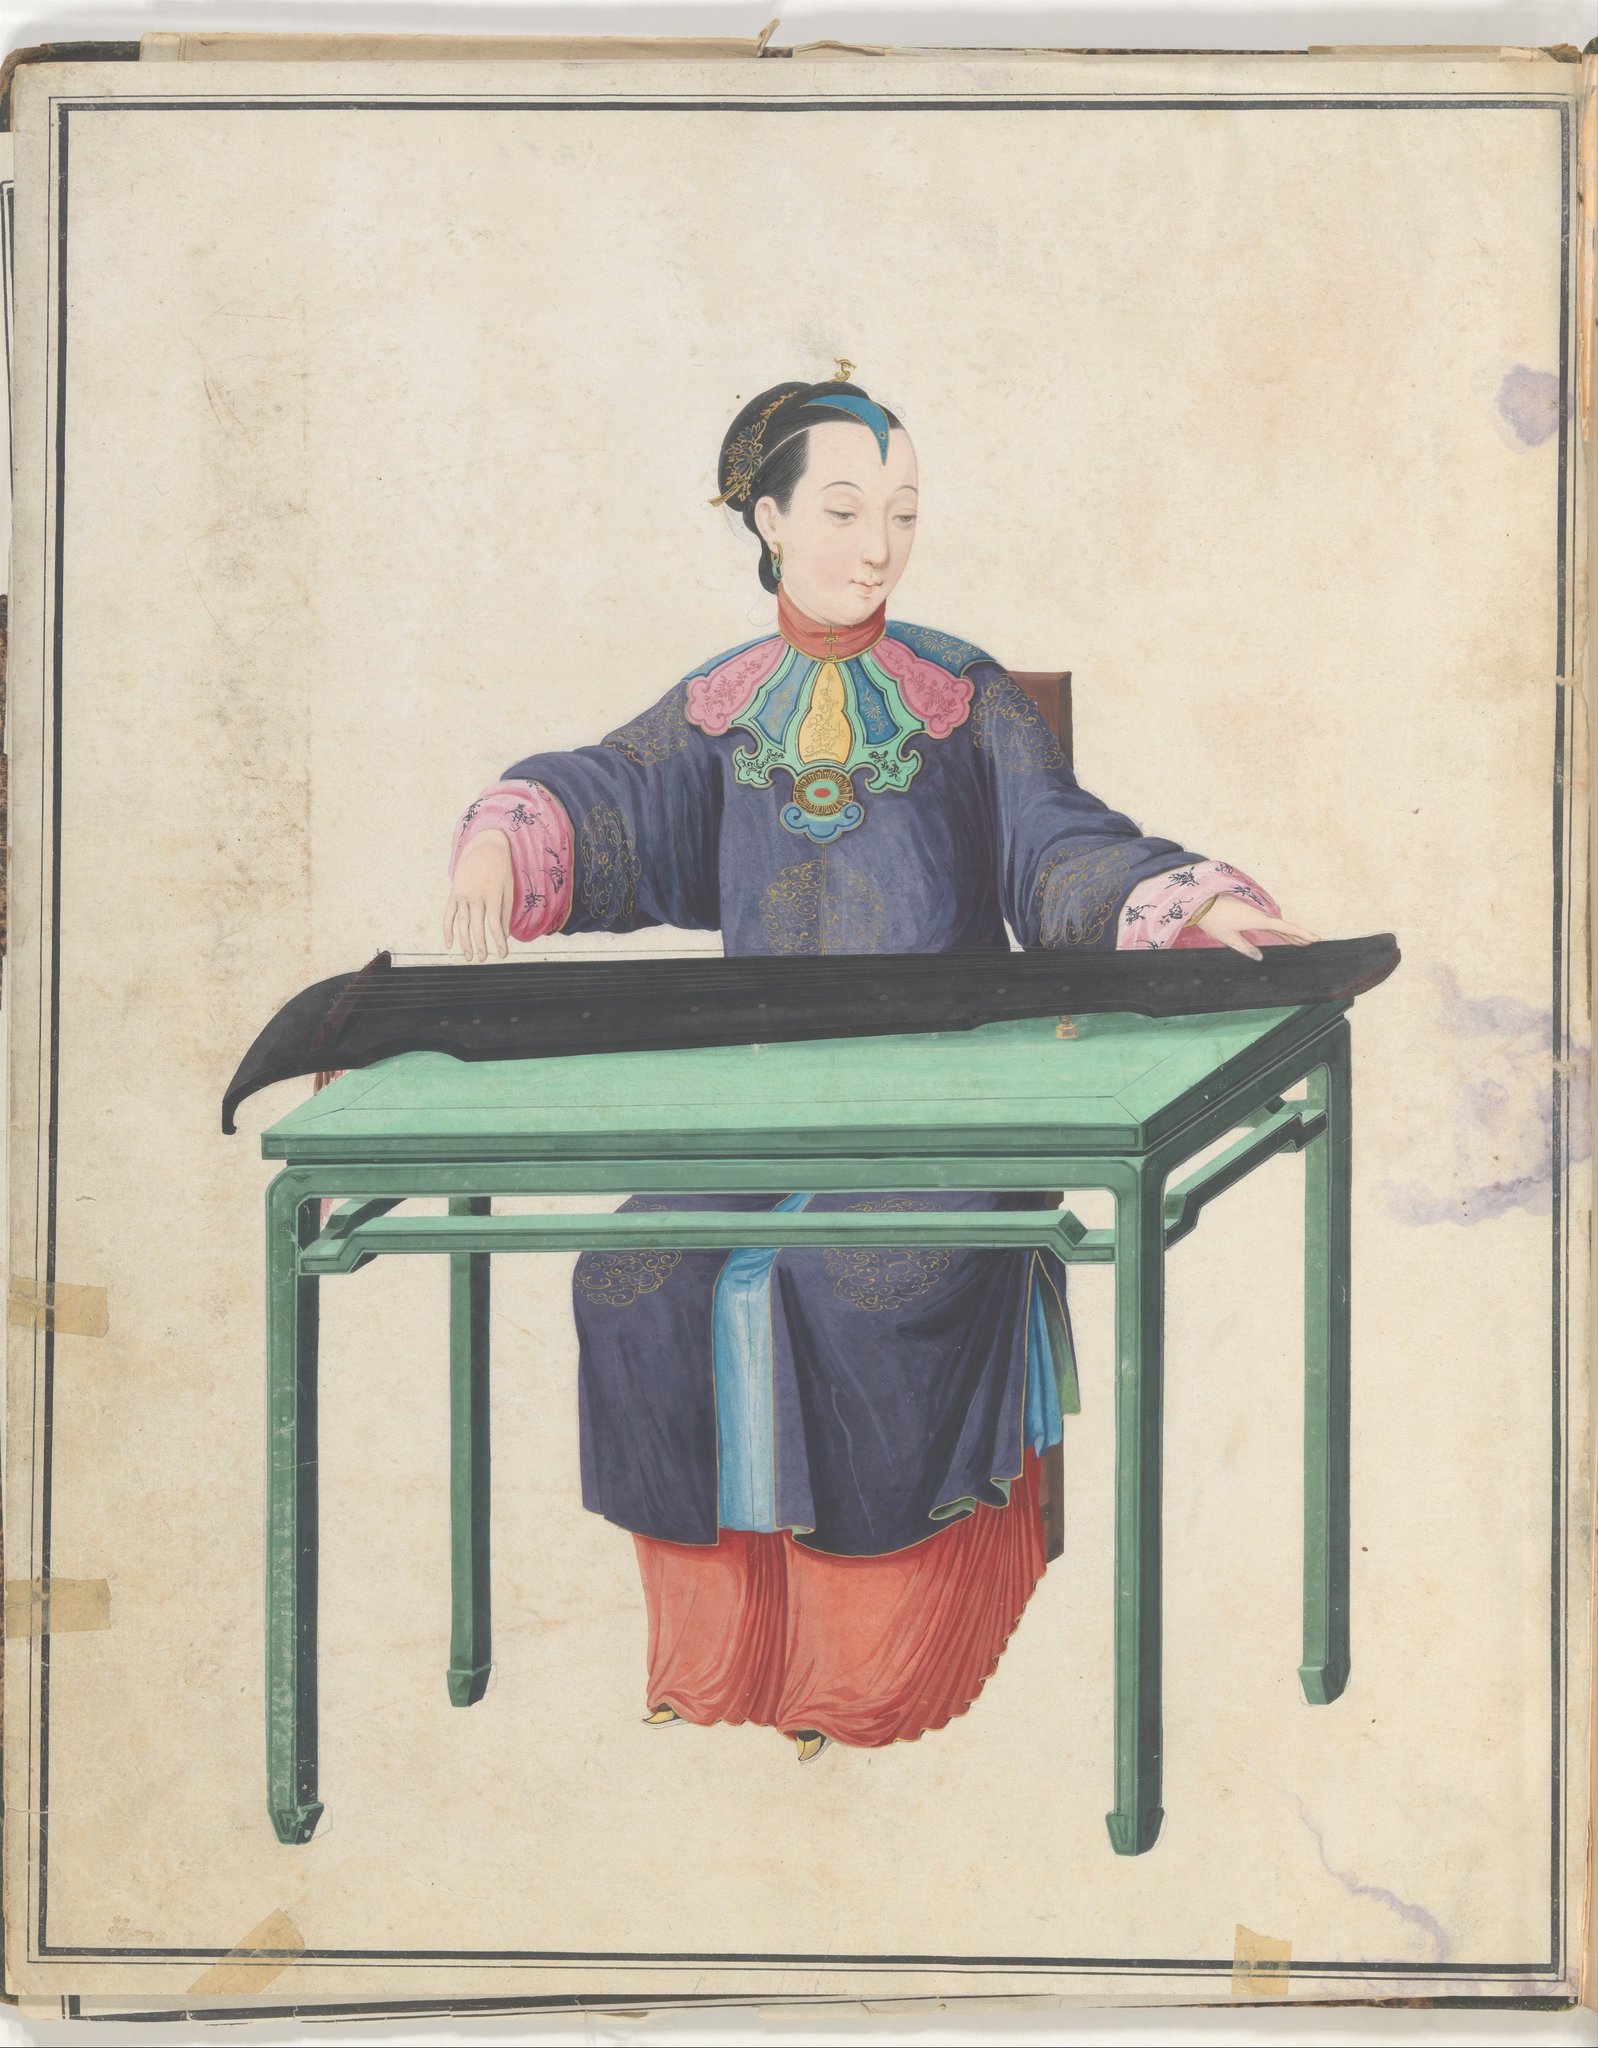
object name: watercolor of musician playing qin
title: Musician playing Guqin (古琴 )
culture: chinese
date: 1767-1800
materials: gouache, paper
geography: china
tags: musical instruments,women,musicians